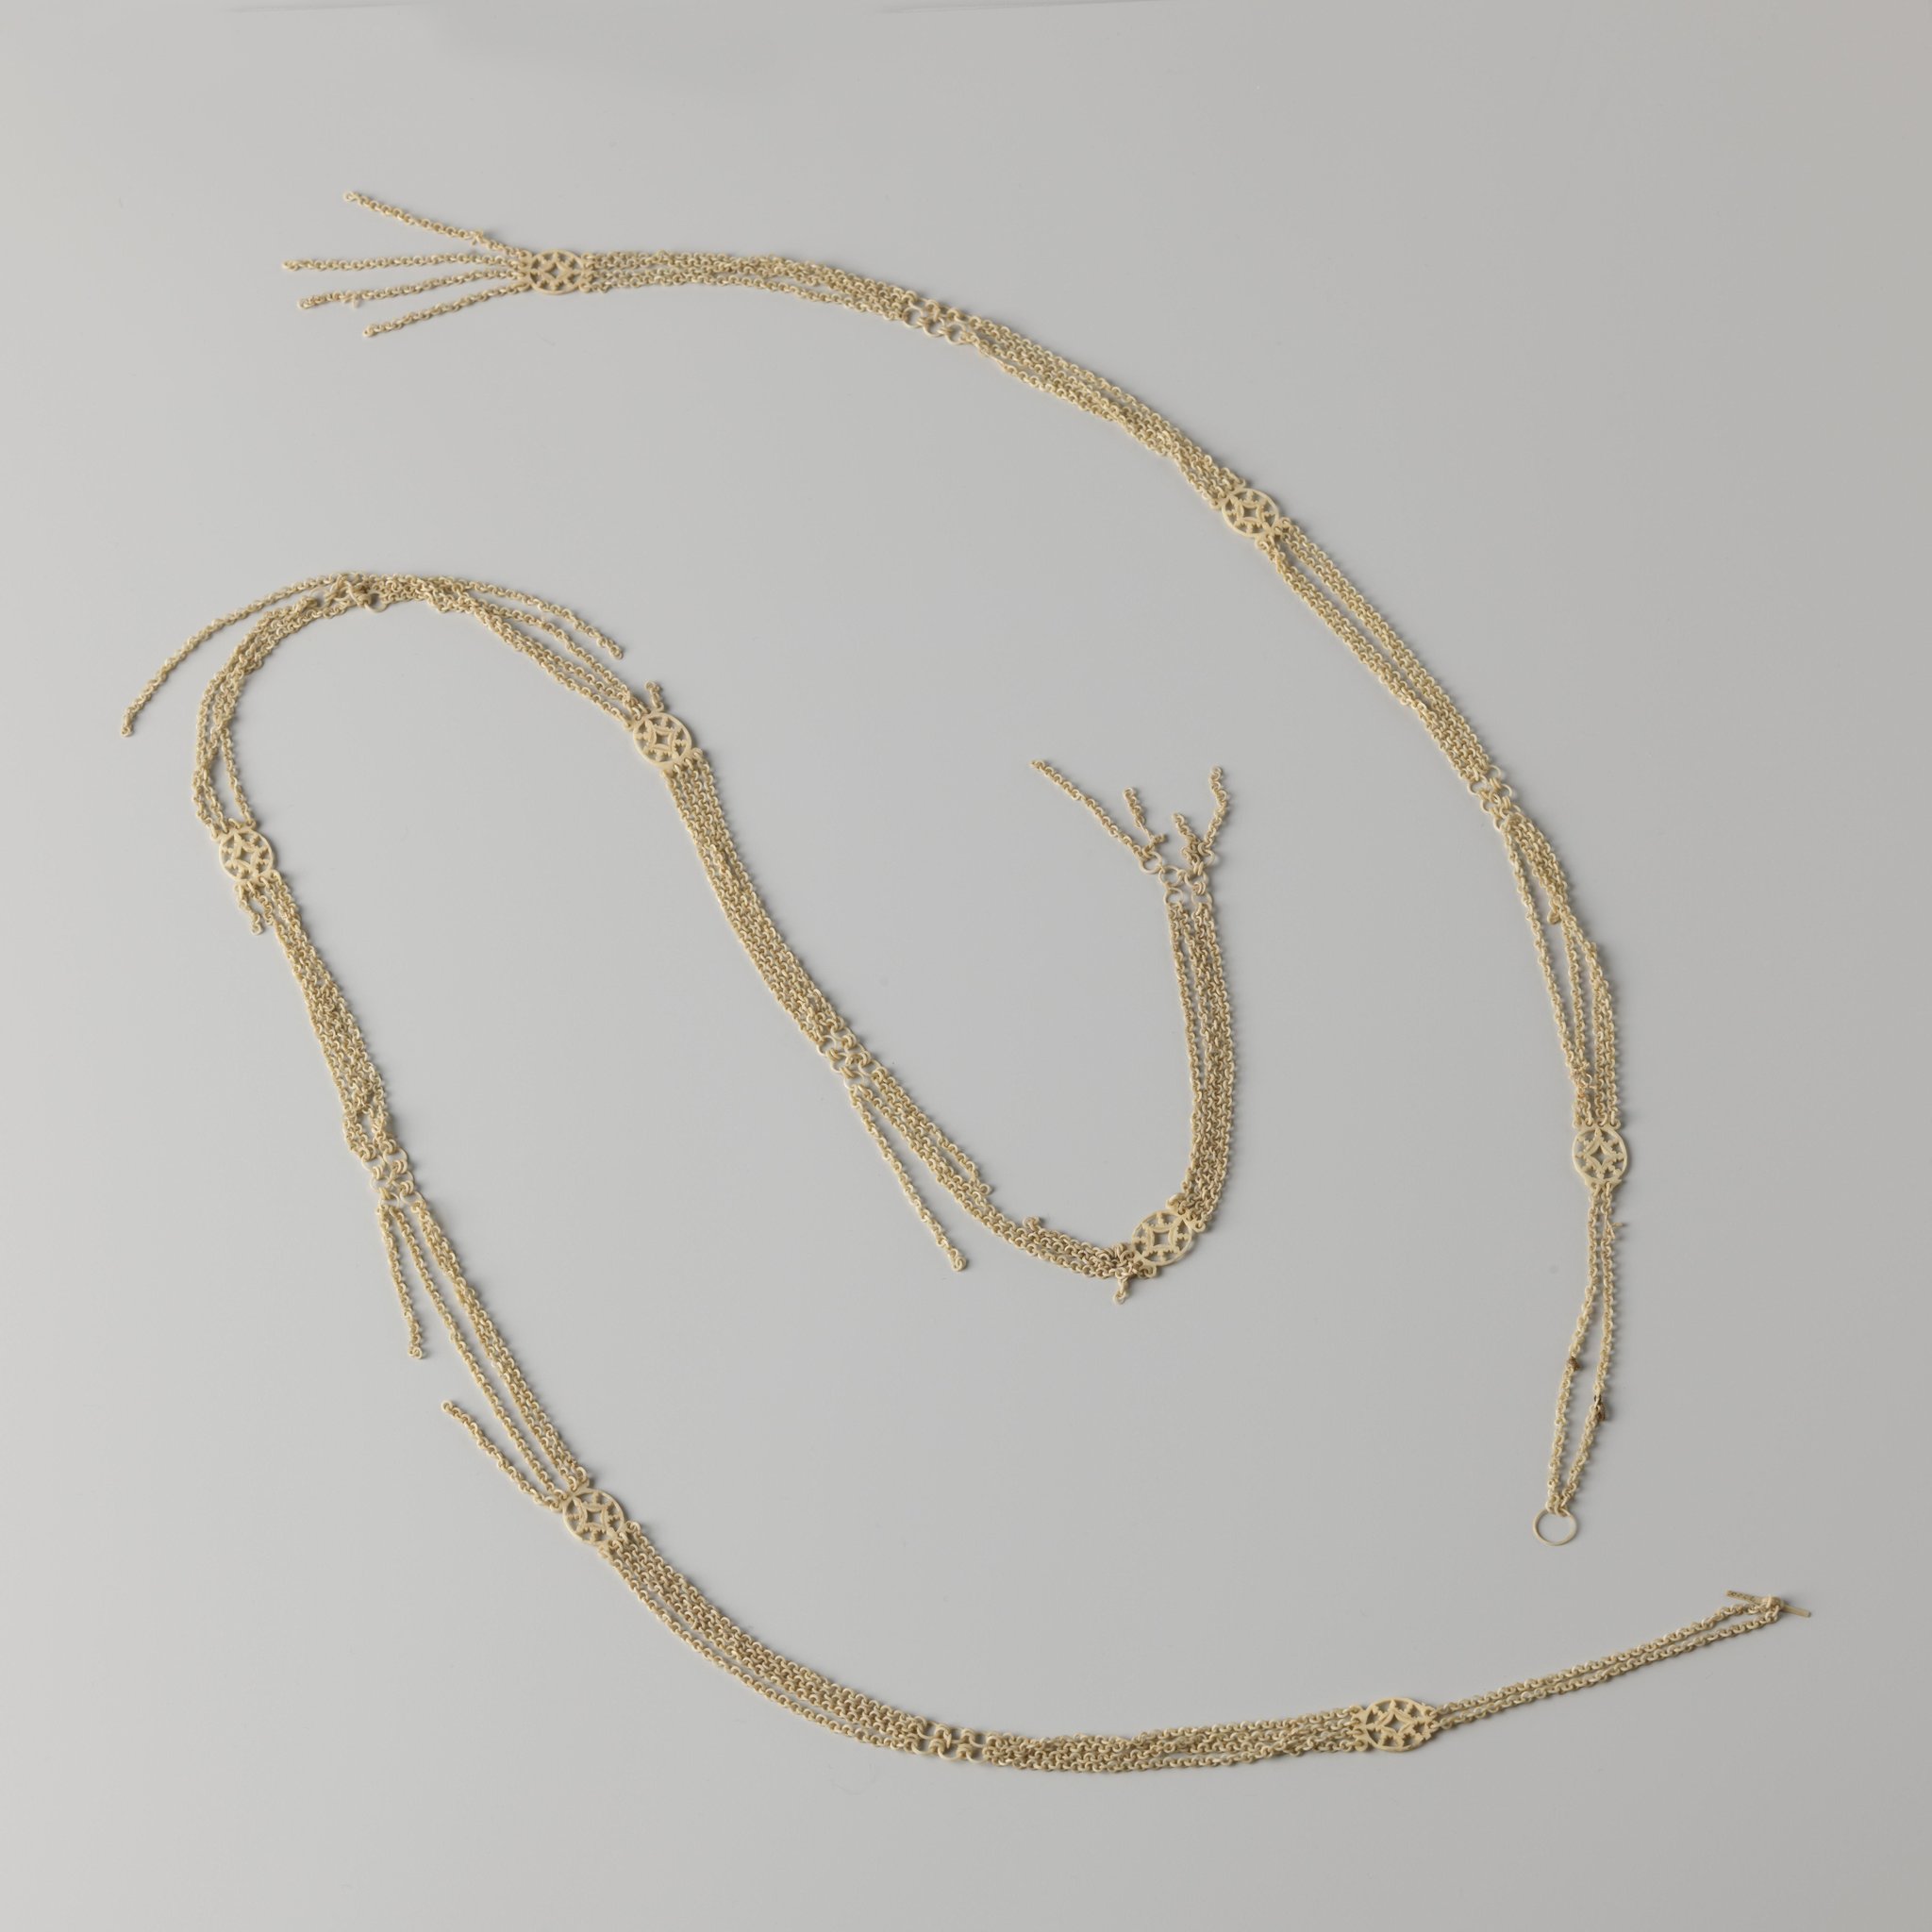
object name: chain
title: Ketting van ivoor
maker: Anonymous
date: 1400-1950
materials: ivory